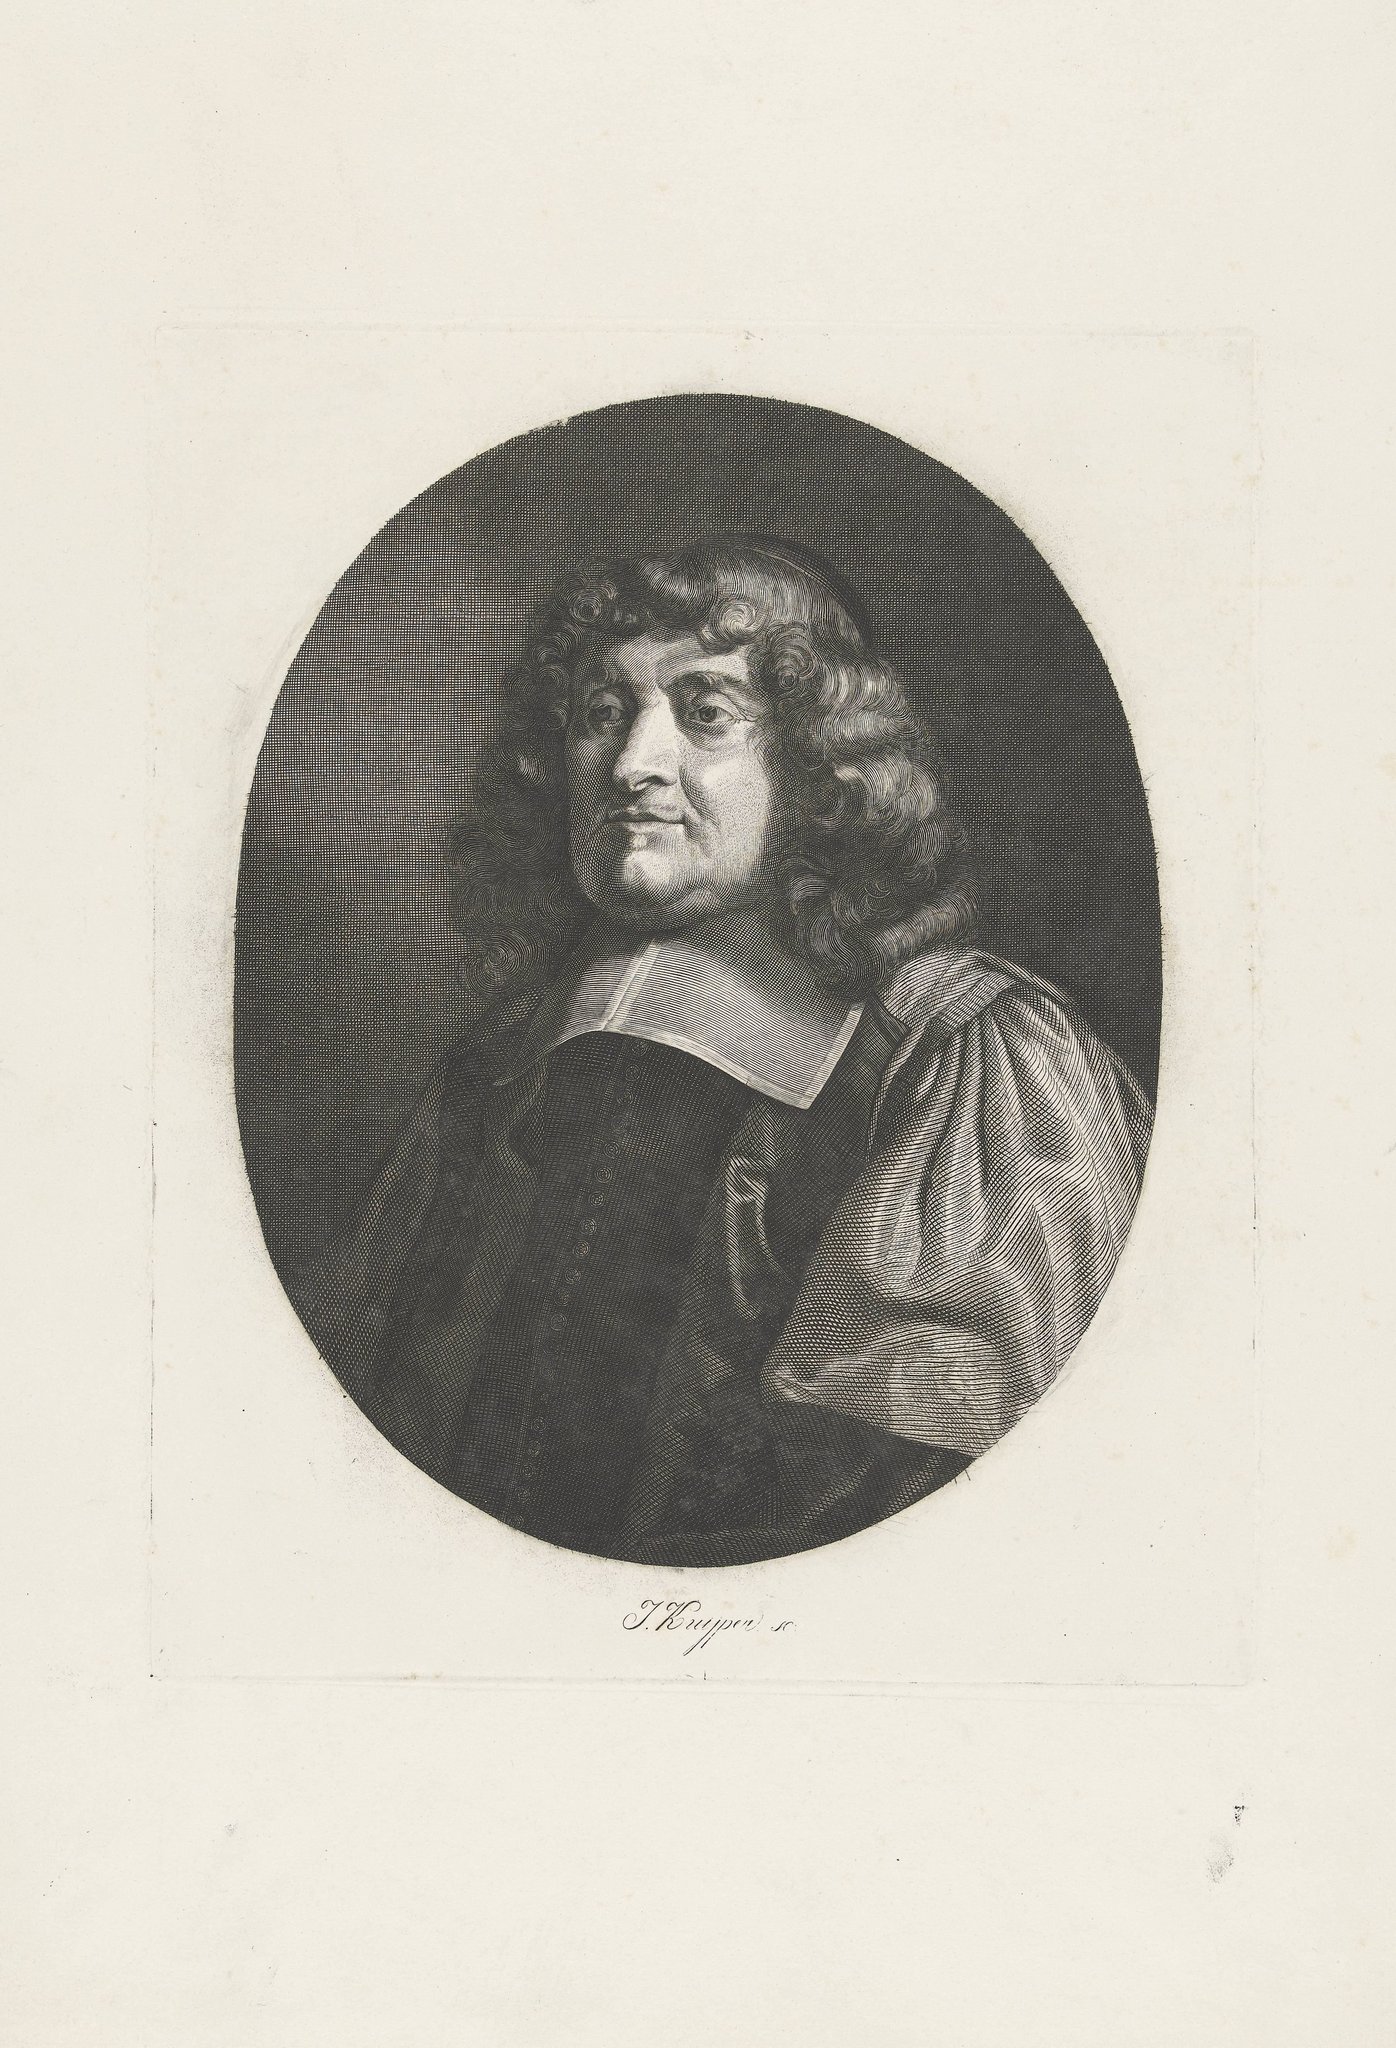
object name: print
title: Portret van een onbekende man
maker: j. kuyper (prentmaker)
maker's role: print maker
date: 1860-1870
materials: paper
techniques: engraving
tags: adult man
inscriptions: collector's mark: Lugt 2228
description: Portretbuste in een ovaal naar links van een onbekende man, dragende een kalot en een bef.